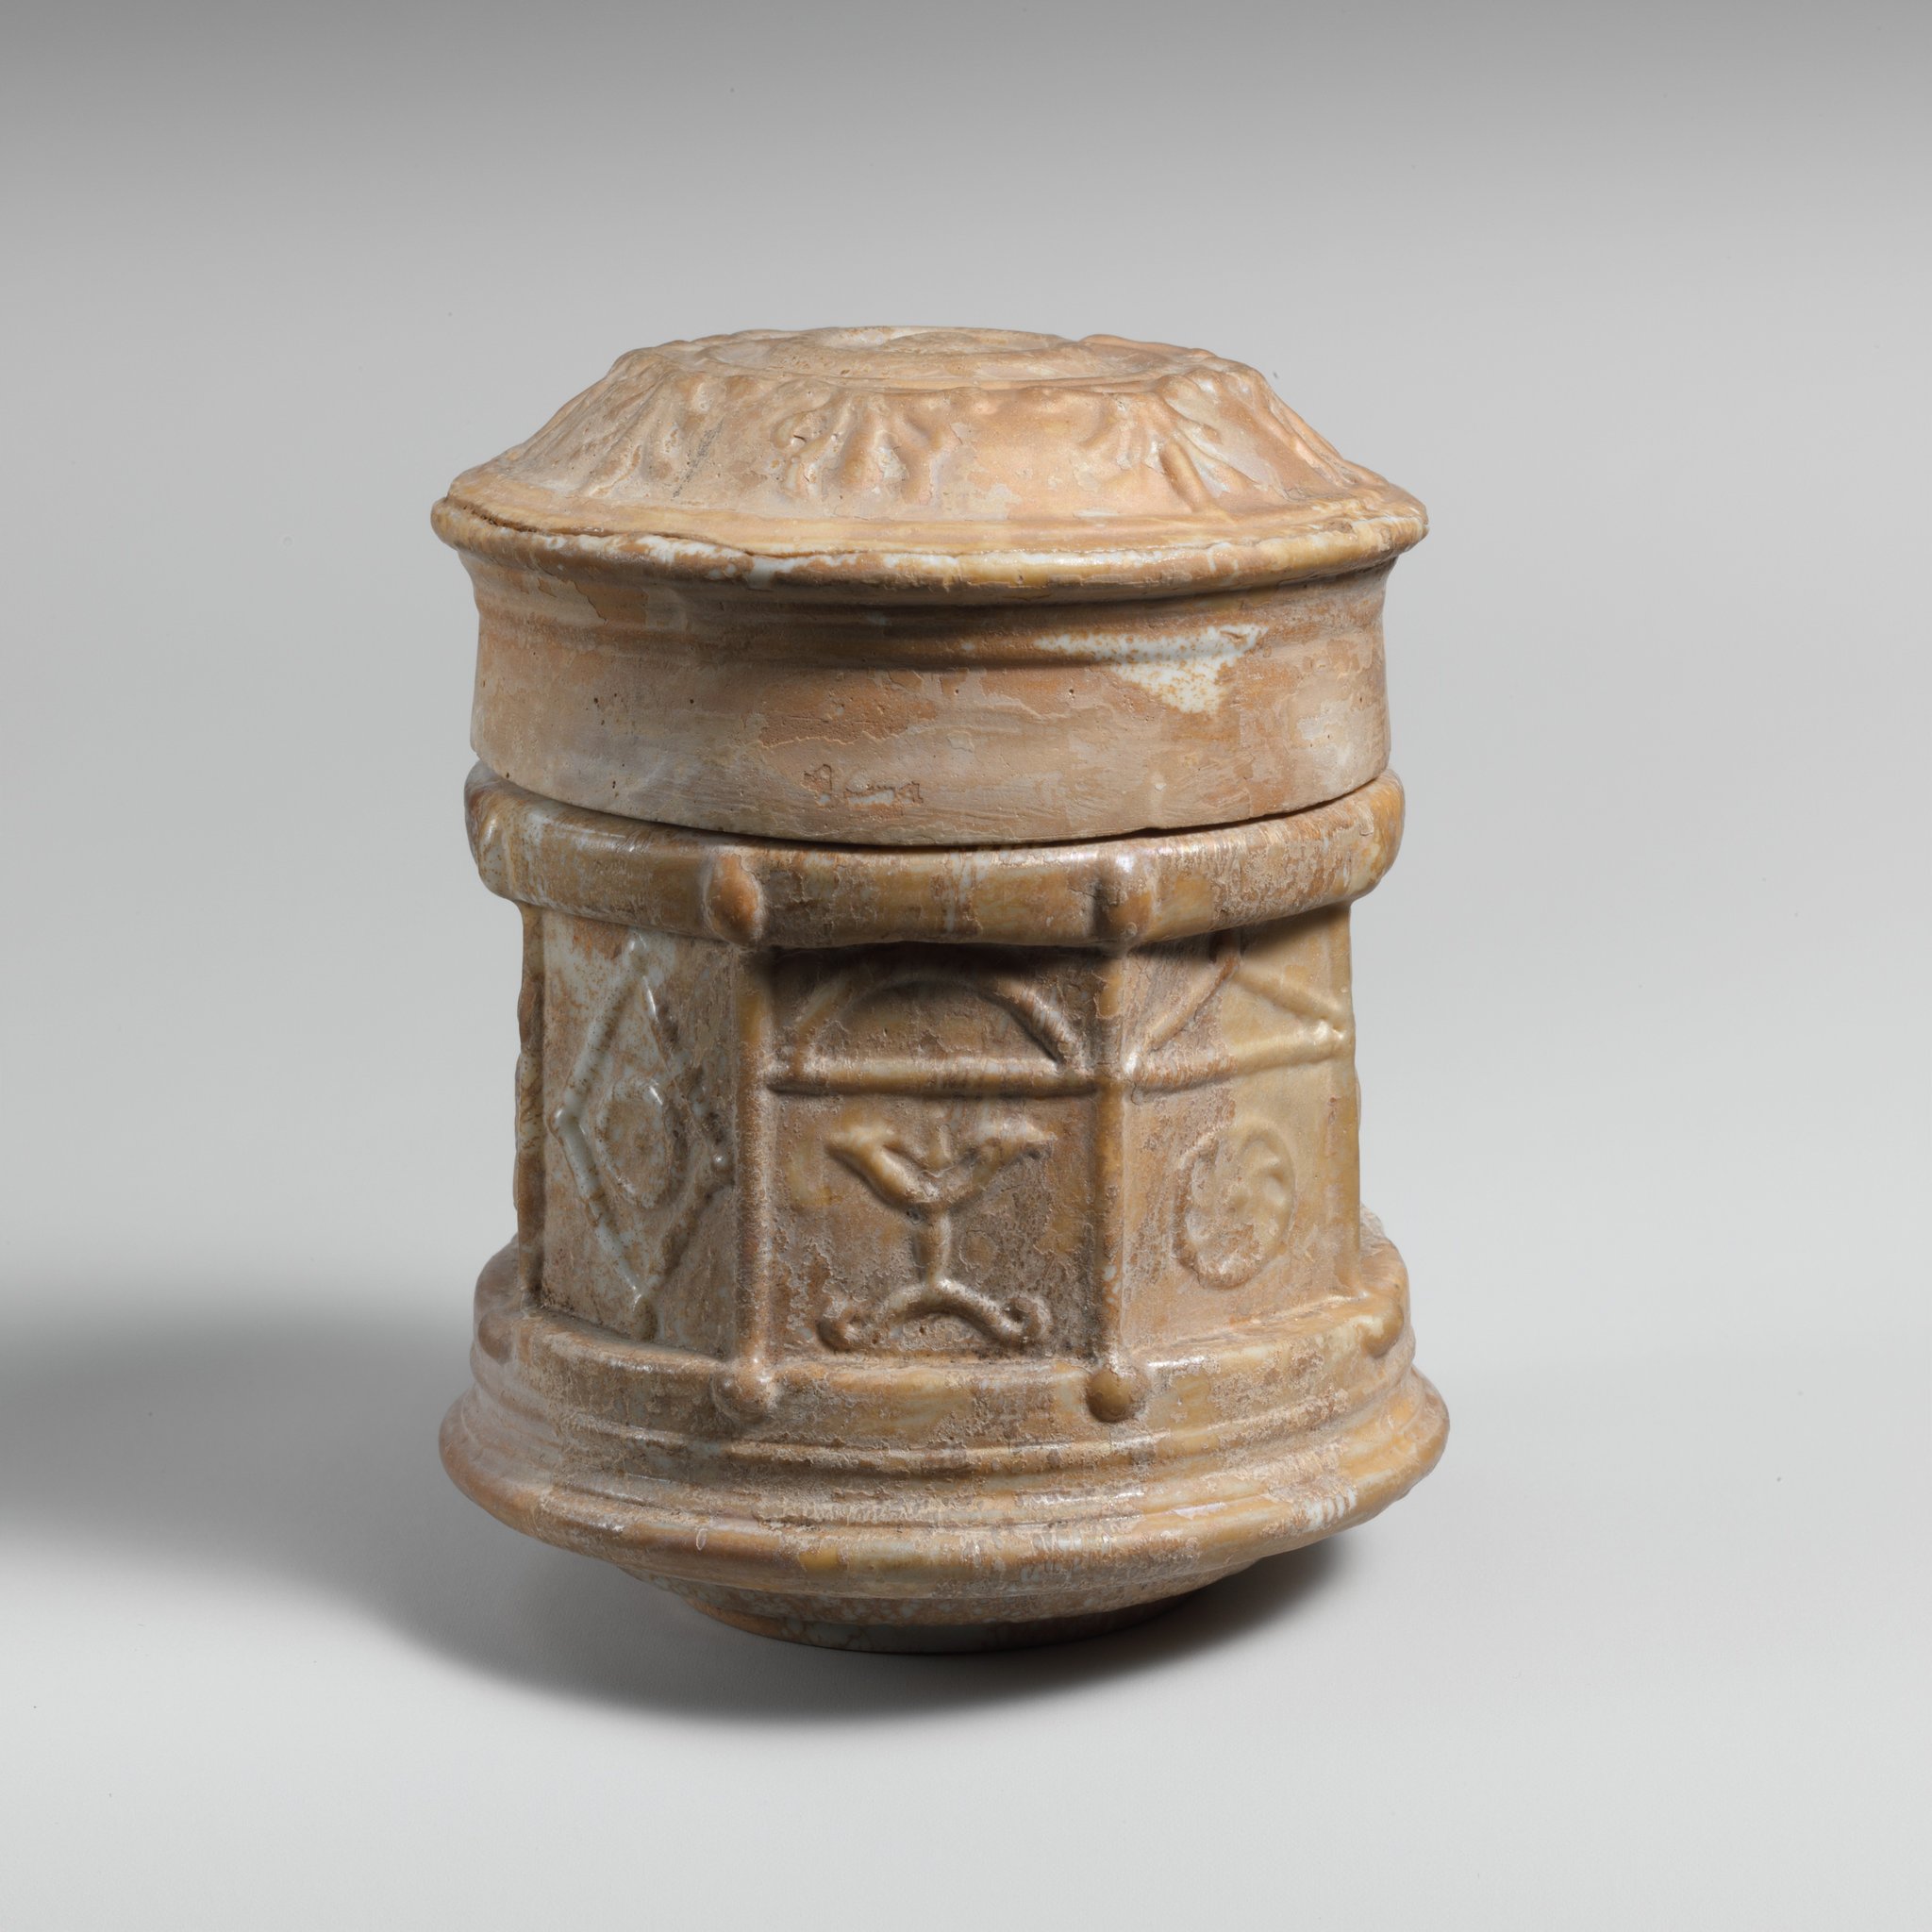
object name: pyxis with lid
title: Glass pyxis with lid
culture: roman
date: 1-50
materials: glass